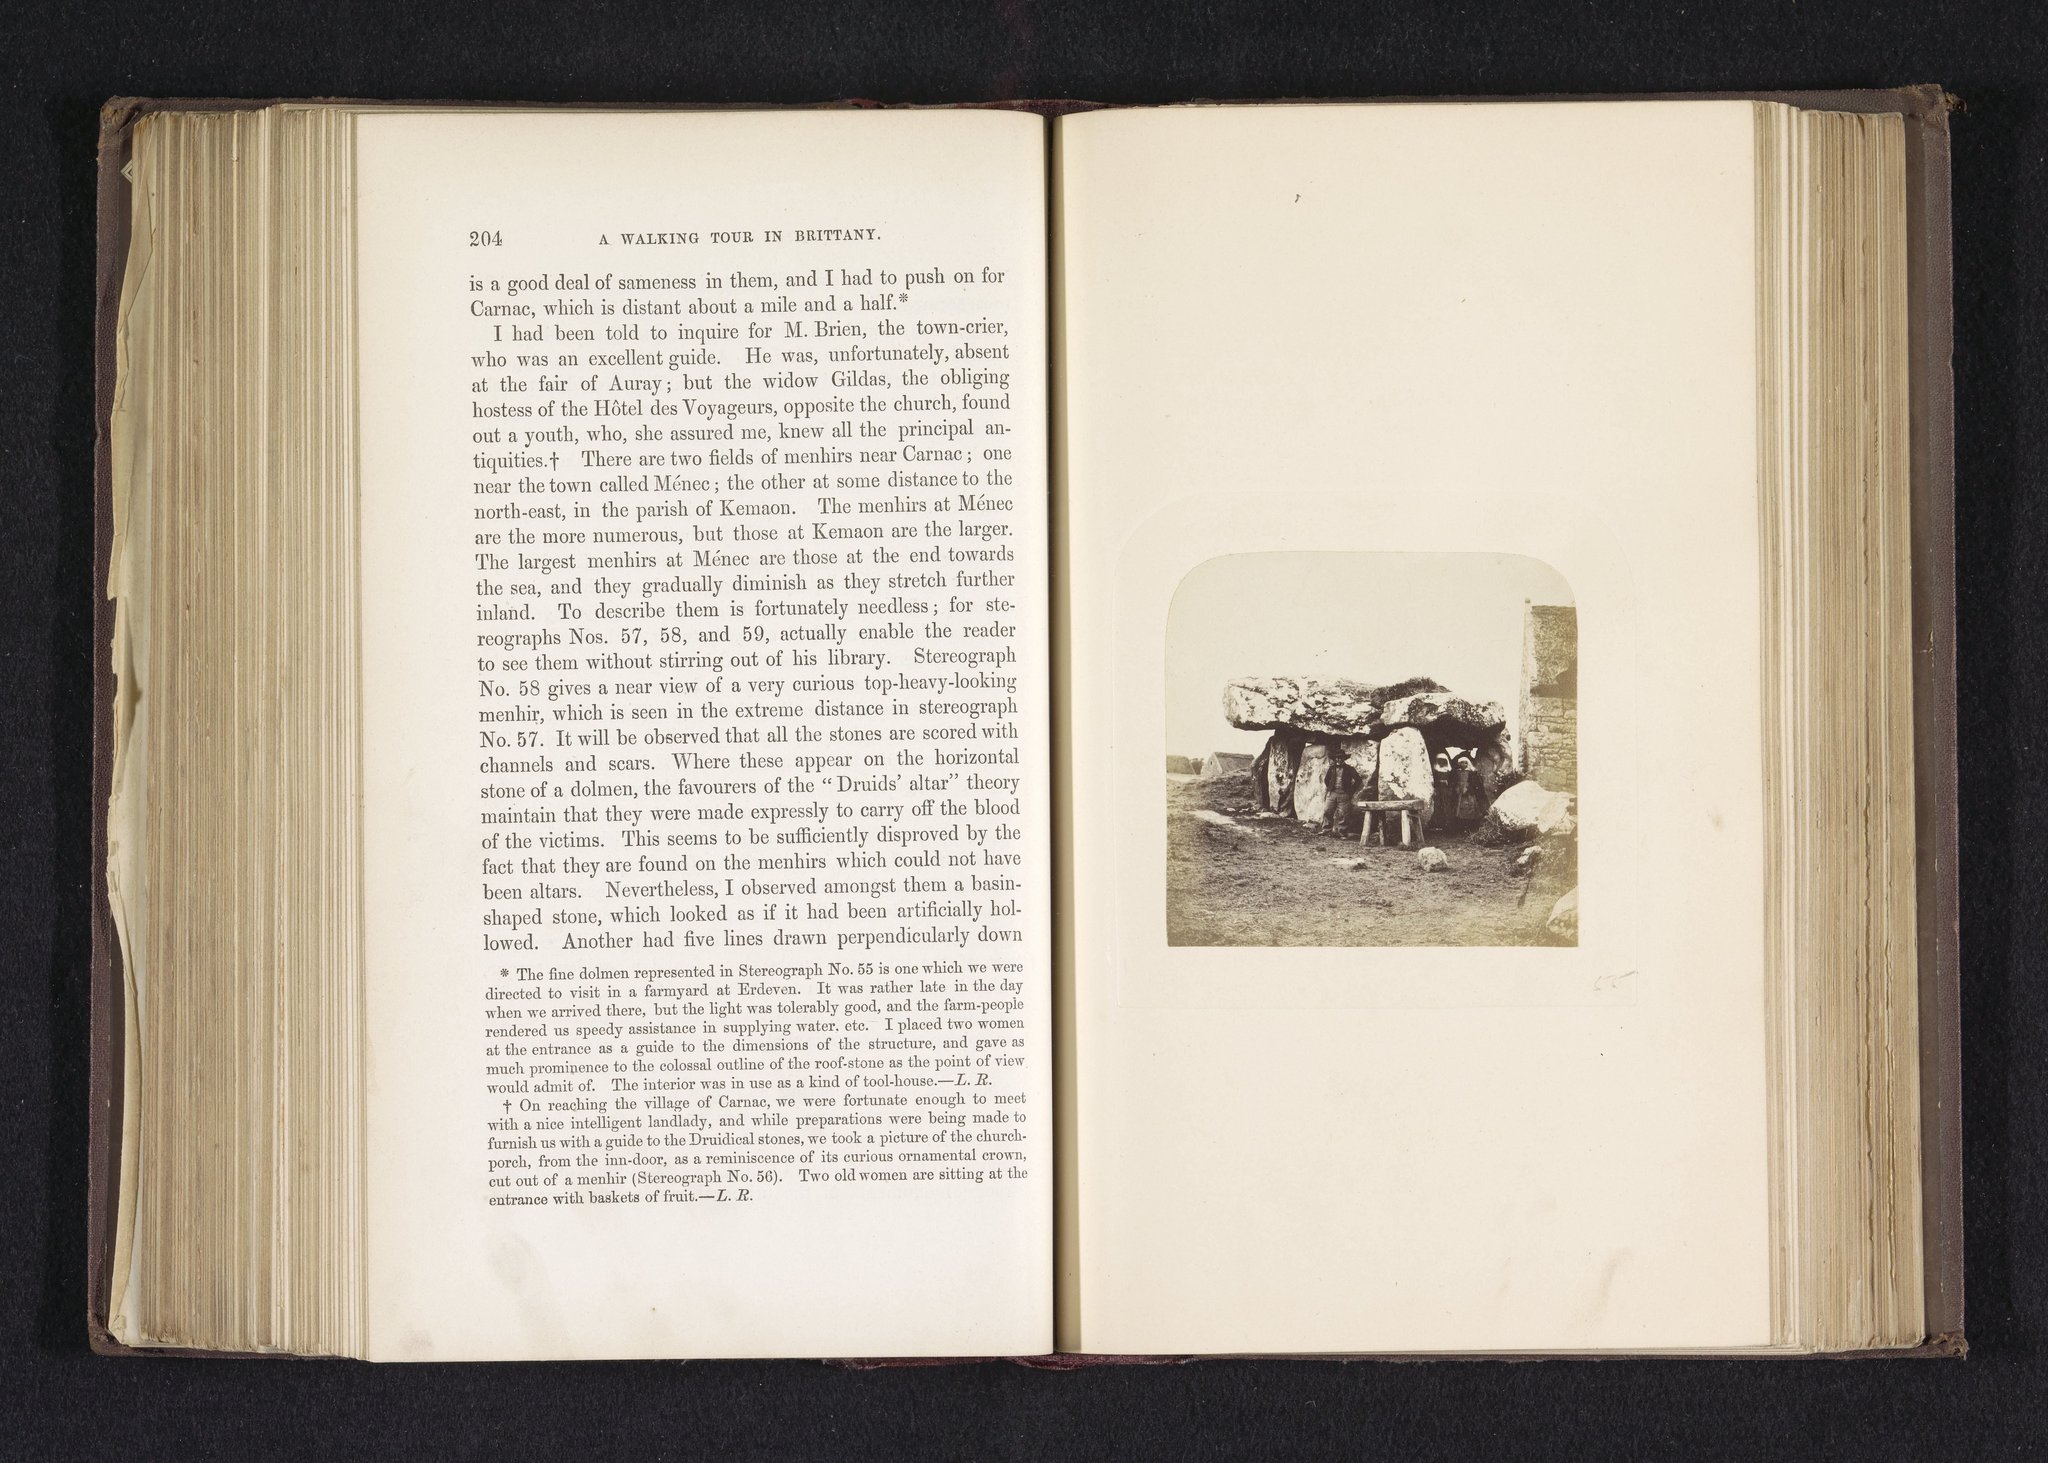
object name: photograph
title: Dolmen op een boerenerf te Erdeven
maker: taylor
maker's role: fotograaf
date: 1850-1859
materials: photographic support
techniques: albumen print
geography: carnac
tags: landscape with menhir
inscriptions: number: ‘55’